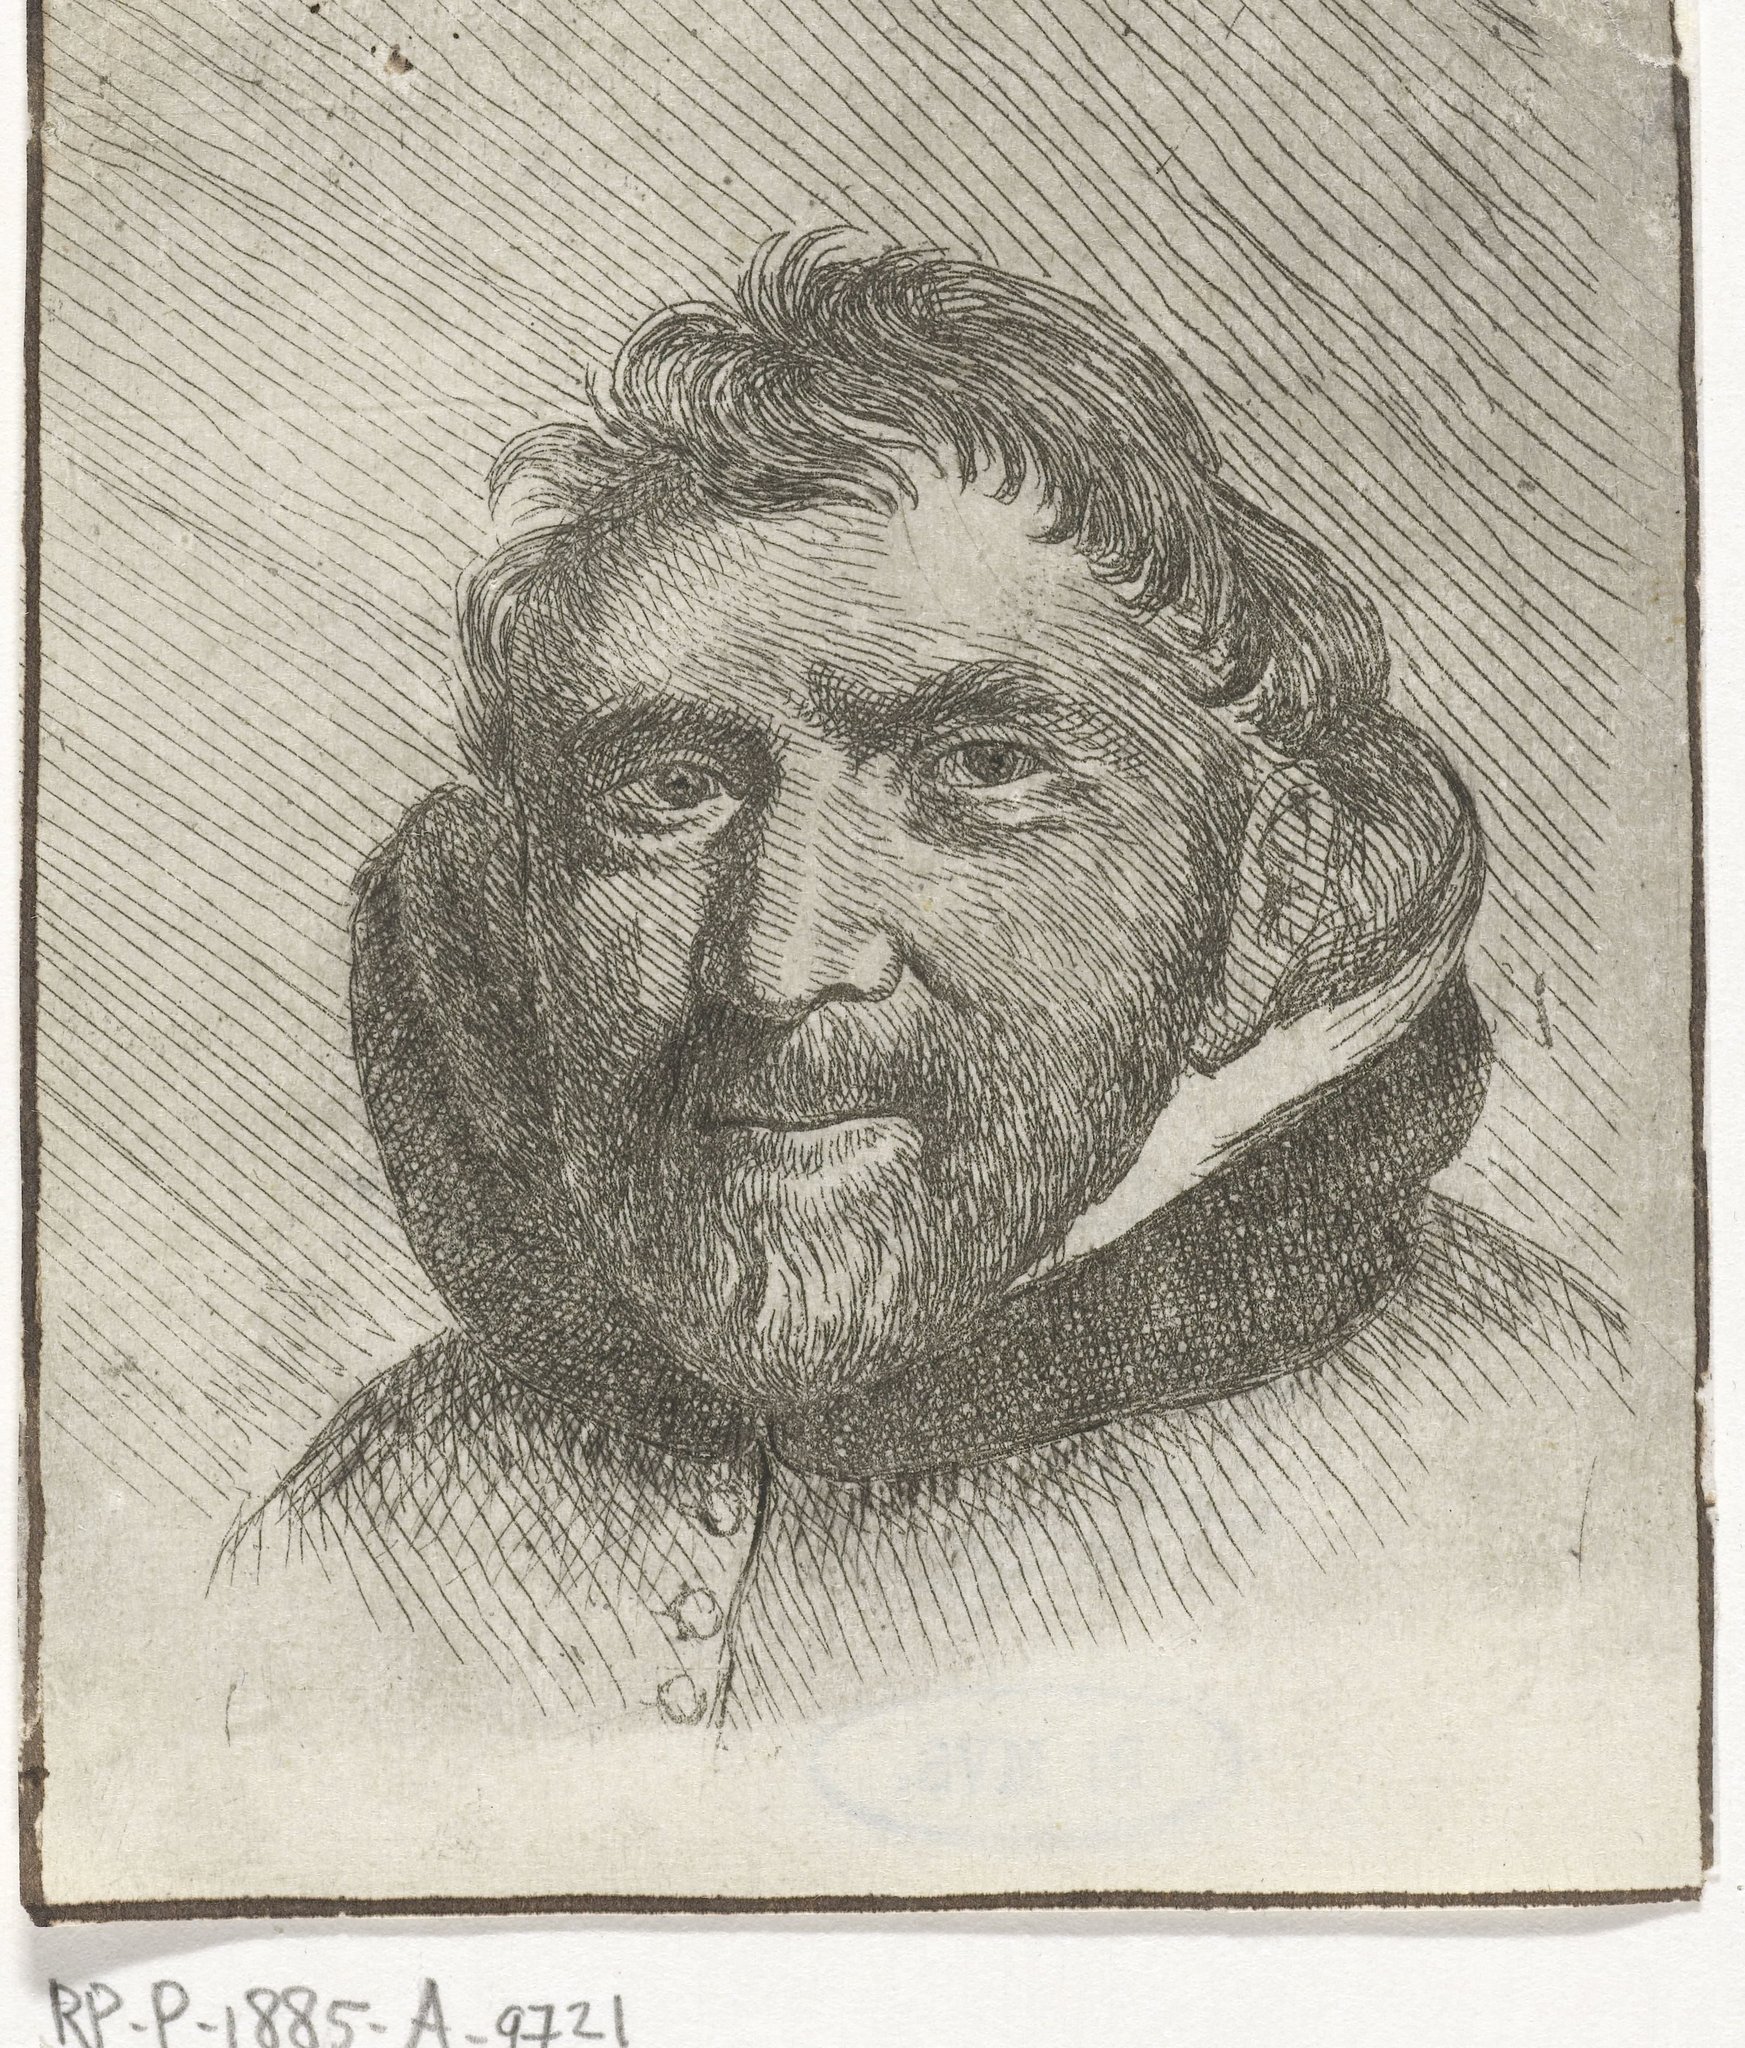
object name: print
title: Portret van Michael Ophovius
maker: johannes hari (i)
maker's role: draughtsman, painter, print maker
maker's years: 1772-1849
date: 1792-1849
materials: paper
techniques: etching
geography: the hague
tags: den bosch, michael ophovius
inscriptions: collector's mark: Lugt 2228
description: Buste van Michael Ophovius, bisschop van Den Bosch.